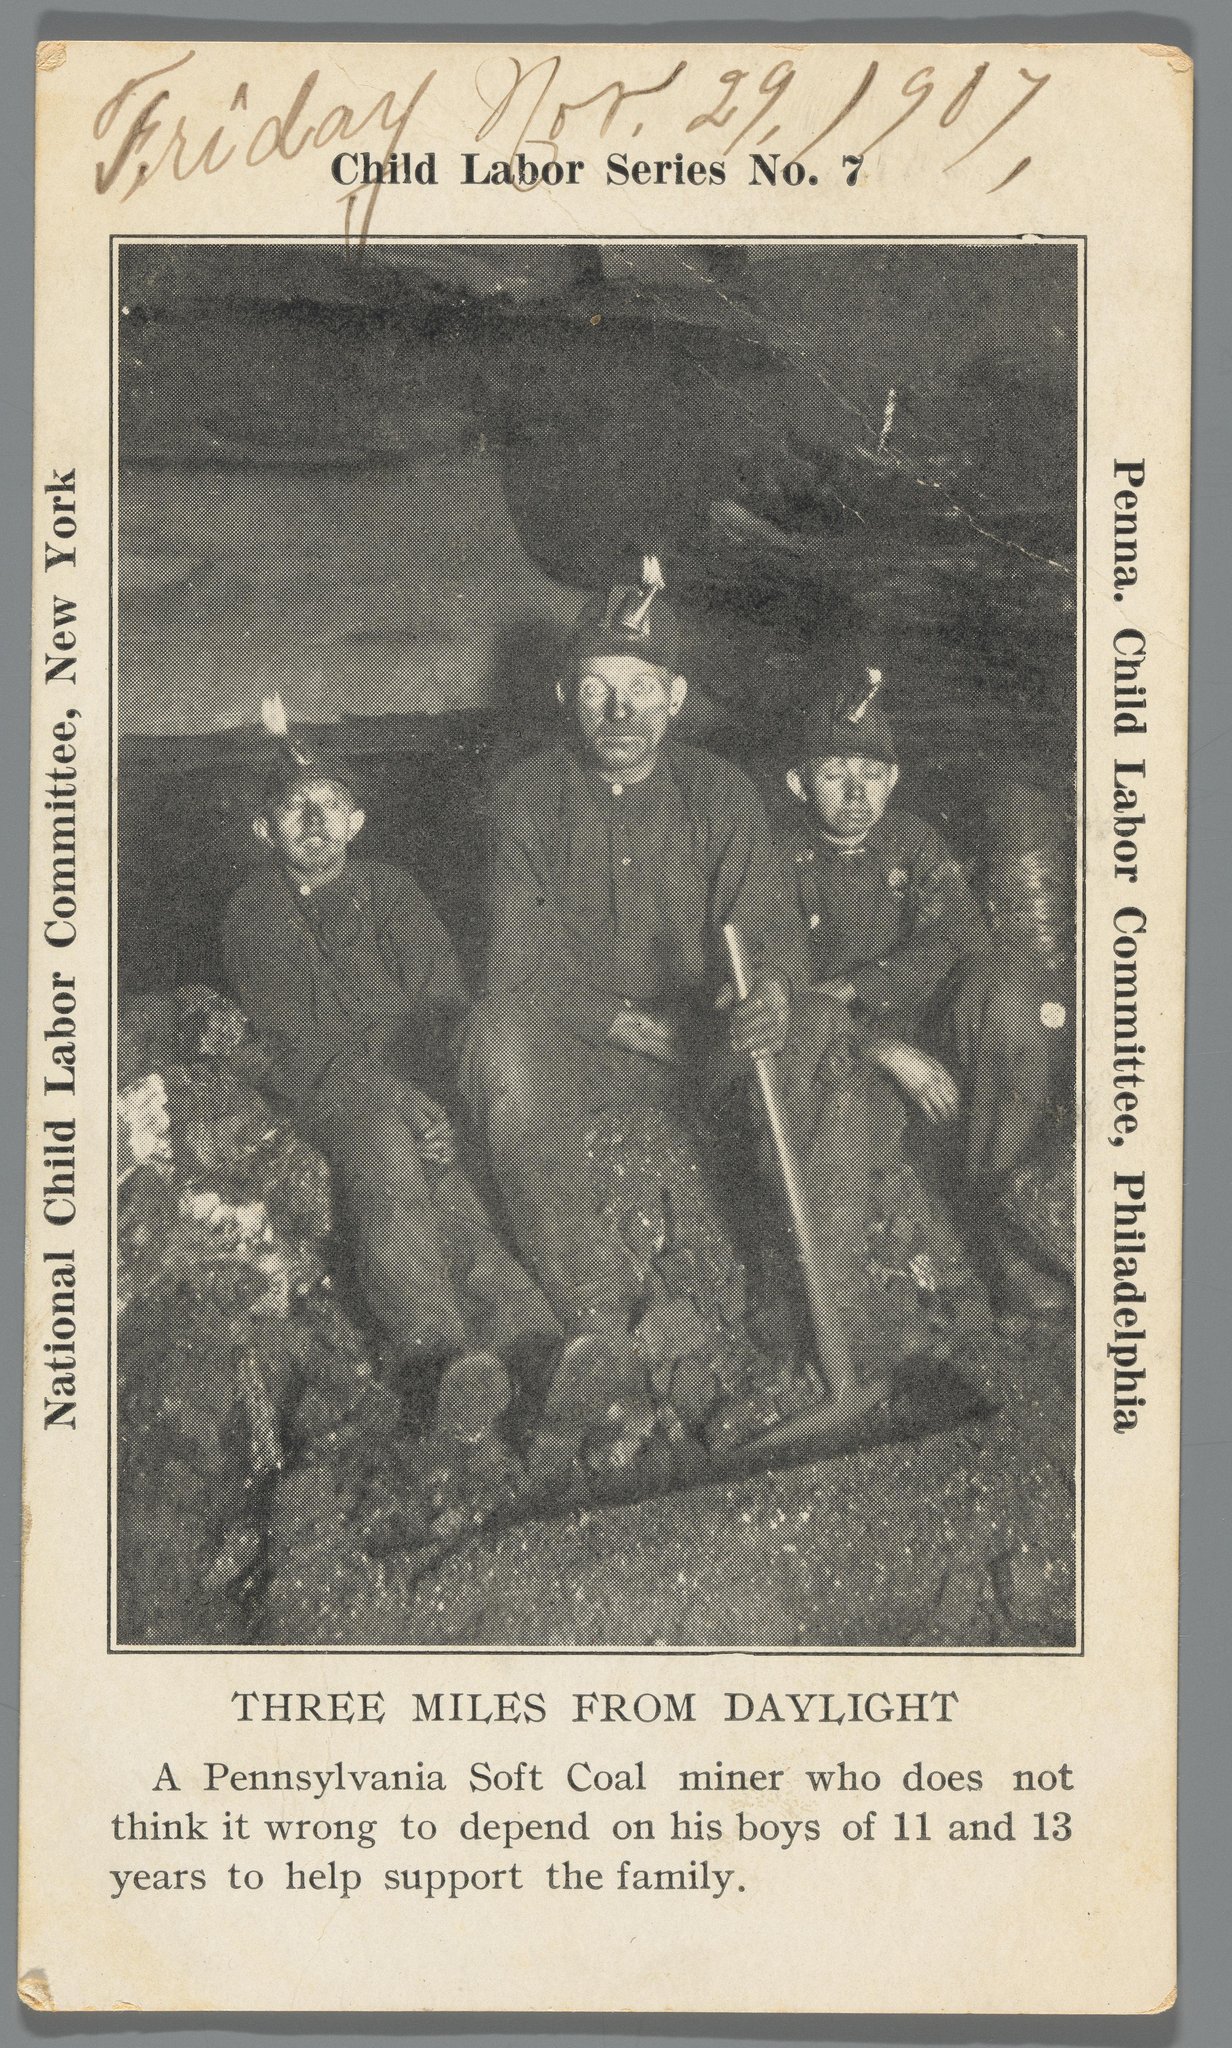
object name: ansichtkaart, prentbriefkaart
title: Drie mijnwerkers, onder wie twee jongens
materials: paper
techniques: autotype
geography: united states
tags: united states of america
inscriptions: inscription: ‘Friday Nov. 29, 1907’, inscription: ‘National Child Labor Committee, New York // Penna. Child Labor Committee, Philadelhia /. THREE MILES FROM DAYLIGHT / A Pennsylvania Soft Coal miner who does not / think it wrong to depend on his boys of 11 and 13 / years to help support the family.’, inscription: ‘Rec’d your letter this a.m. / Was sure glad to get it. / I’ll be home [?] Sat. / evening on the / short train if / nothing happens. / Kate. // Mr. F.F. Re[….] / Russelville / Tenn.’